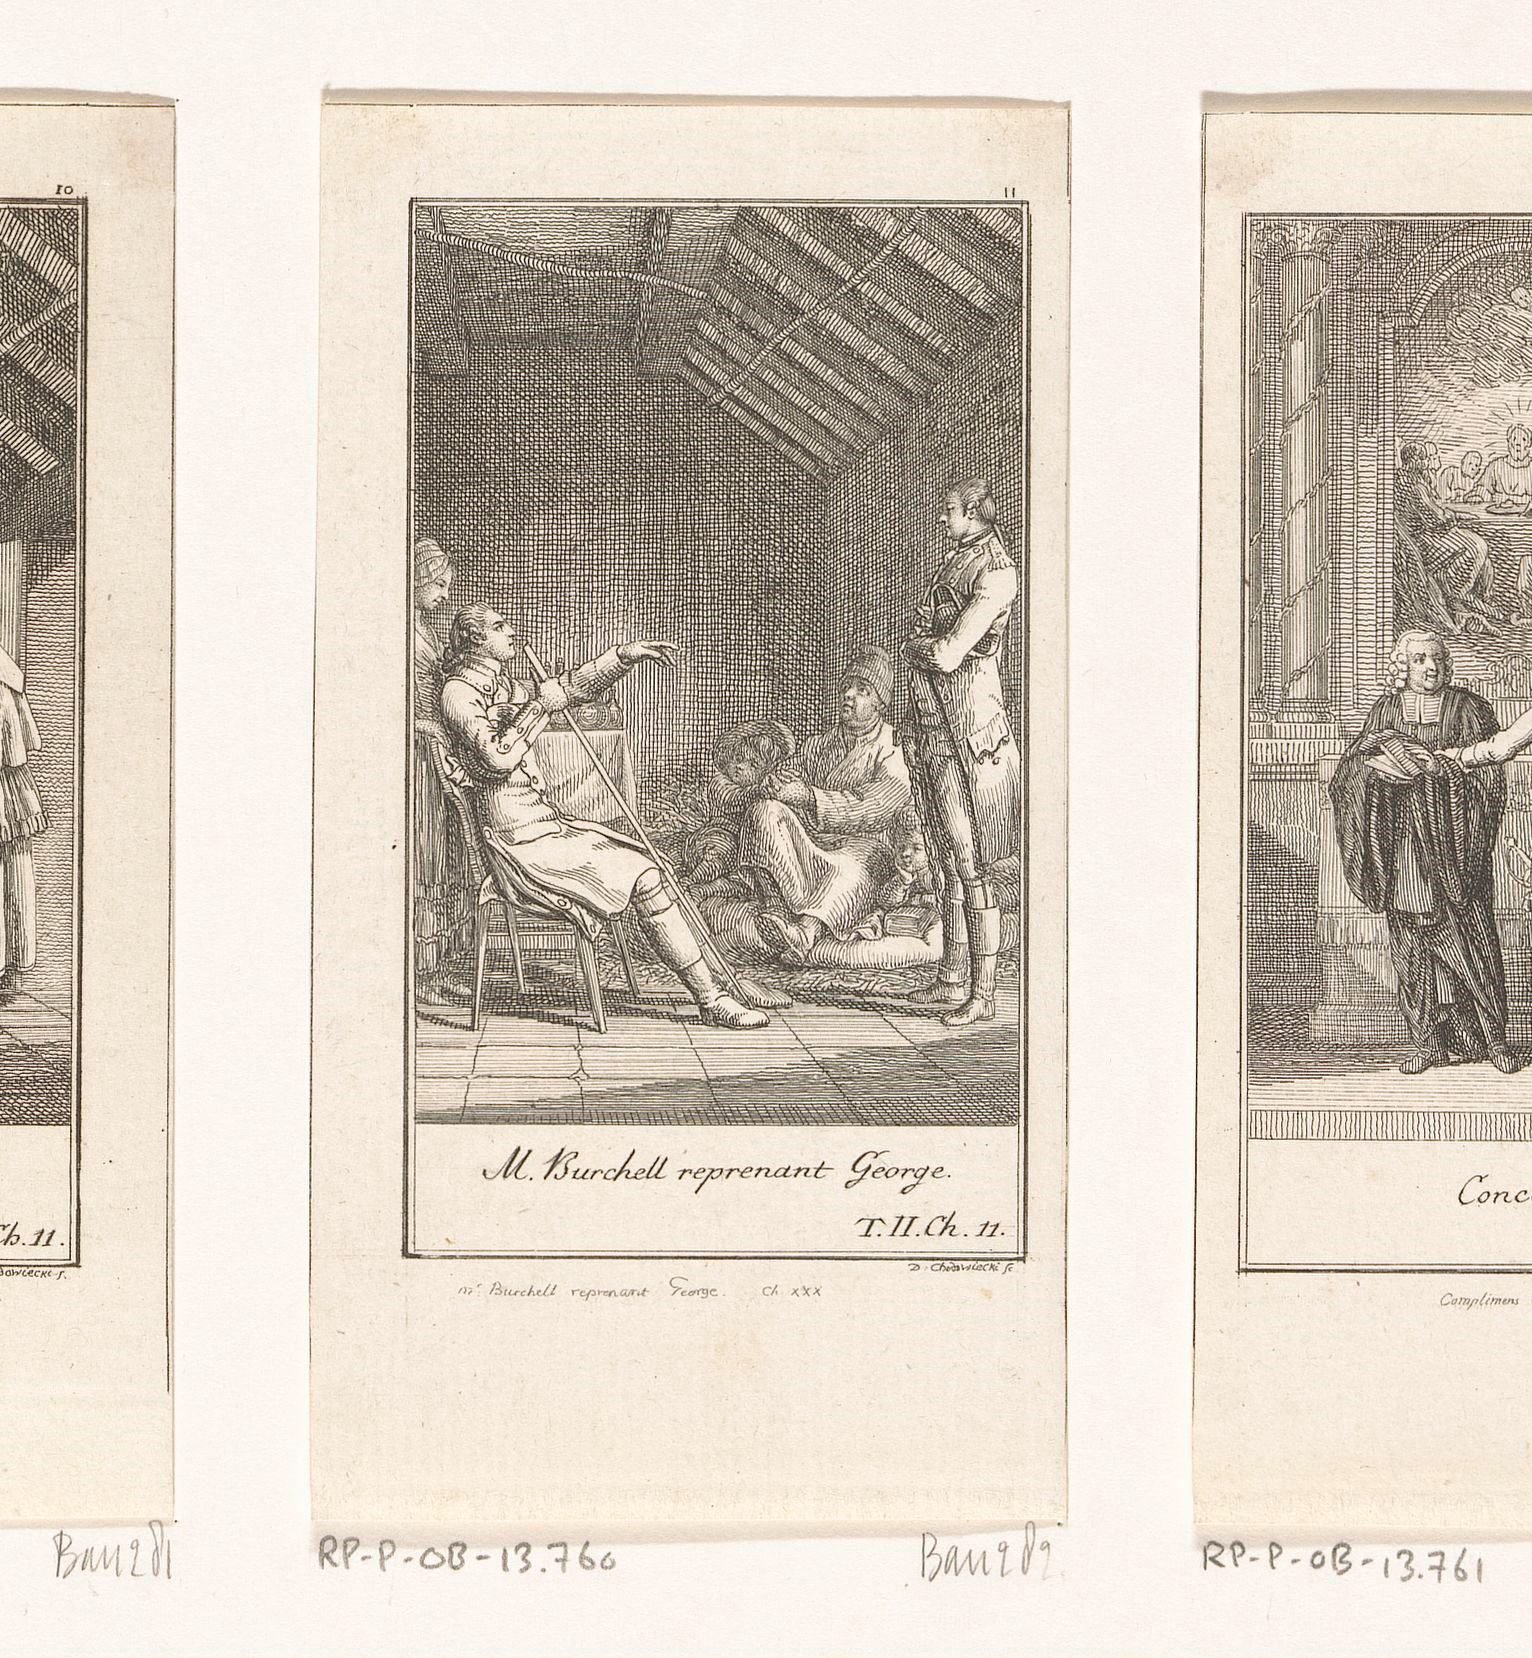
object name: print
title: Mr. Burchell berispt George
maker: daniel nikolaus chodowiecki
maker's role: draughtsman, print maker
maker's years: 1726-1801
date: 1776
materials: paper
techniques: etching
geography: berlin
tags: london, oliver goldsmith, prison, jail, (goldsmith, the vicar of wakefield) specific works of literature (with author, title)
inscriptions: collector's mark: Lugt 2228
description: Interieur van een cel met in de achtergrond op de grond Charles Primrose met twee kinderen. Op dit punt in het verhaal wordt duidelijk dat Mr. Burchell eigenlijk Sir William Thornhill in vermomming is. Zittend op een stoel spreekt hij George berispend toe. Rechtsboven genummerd: 11.